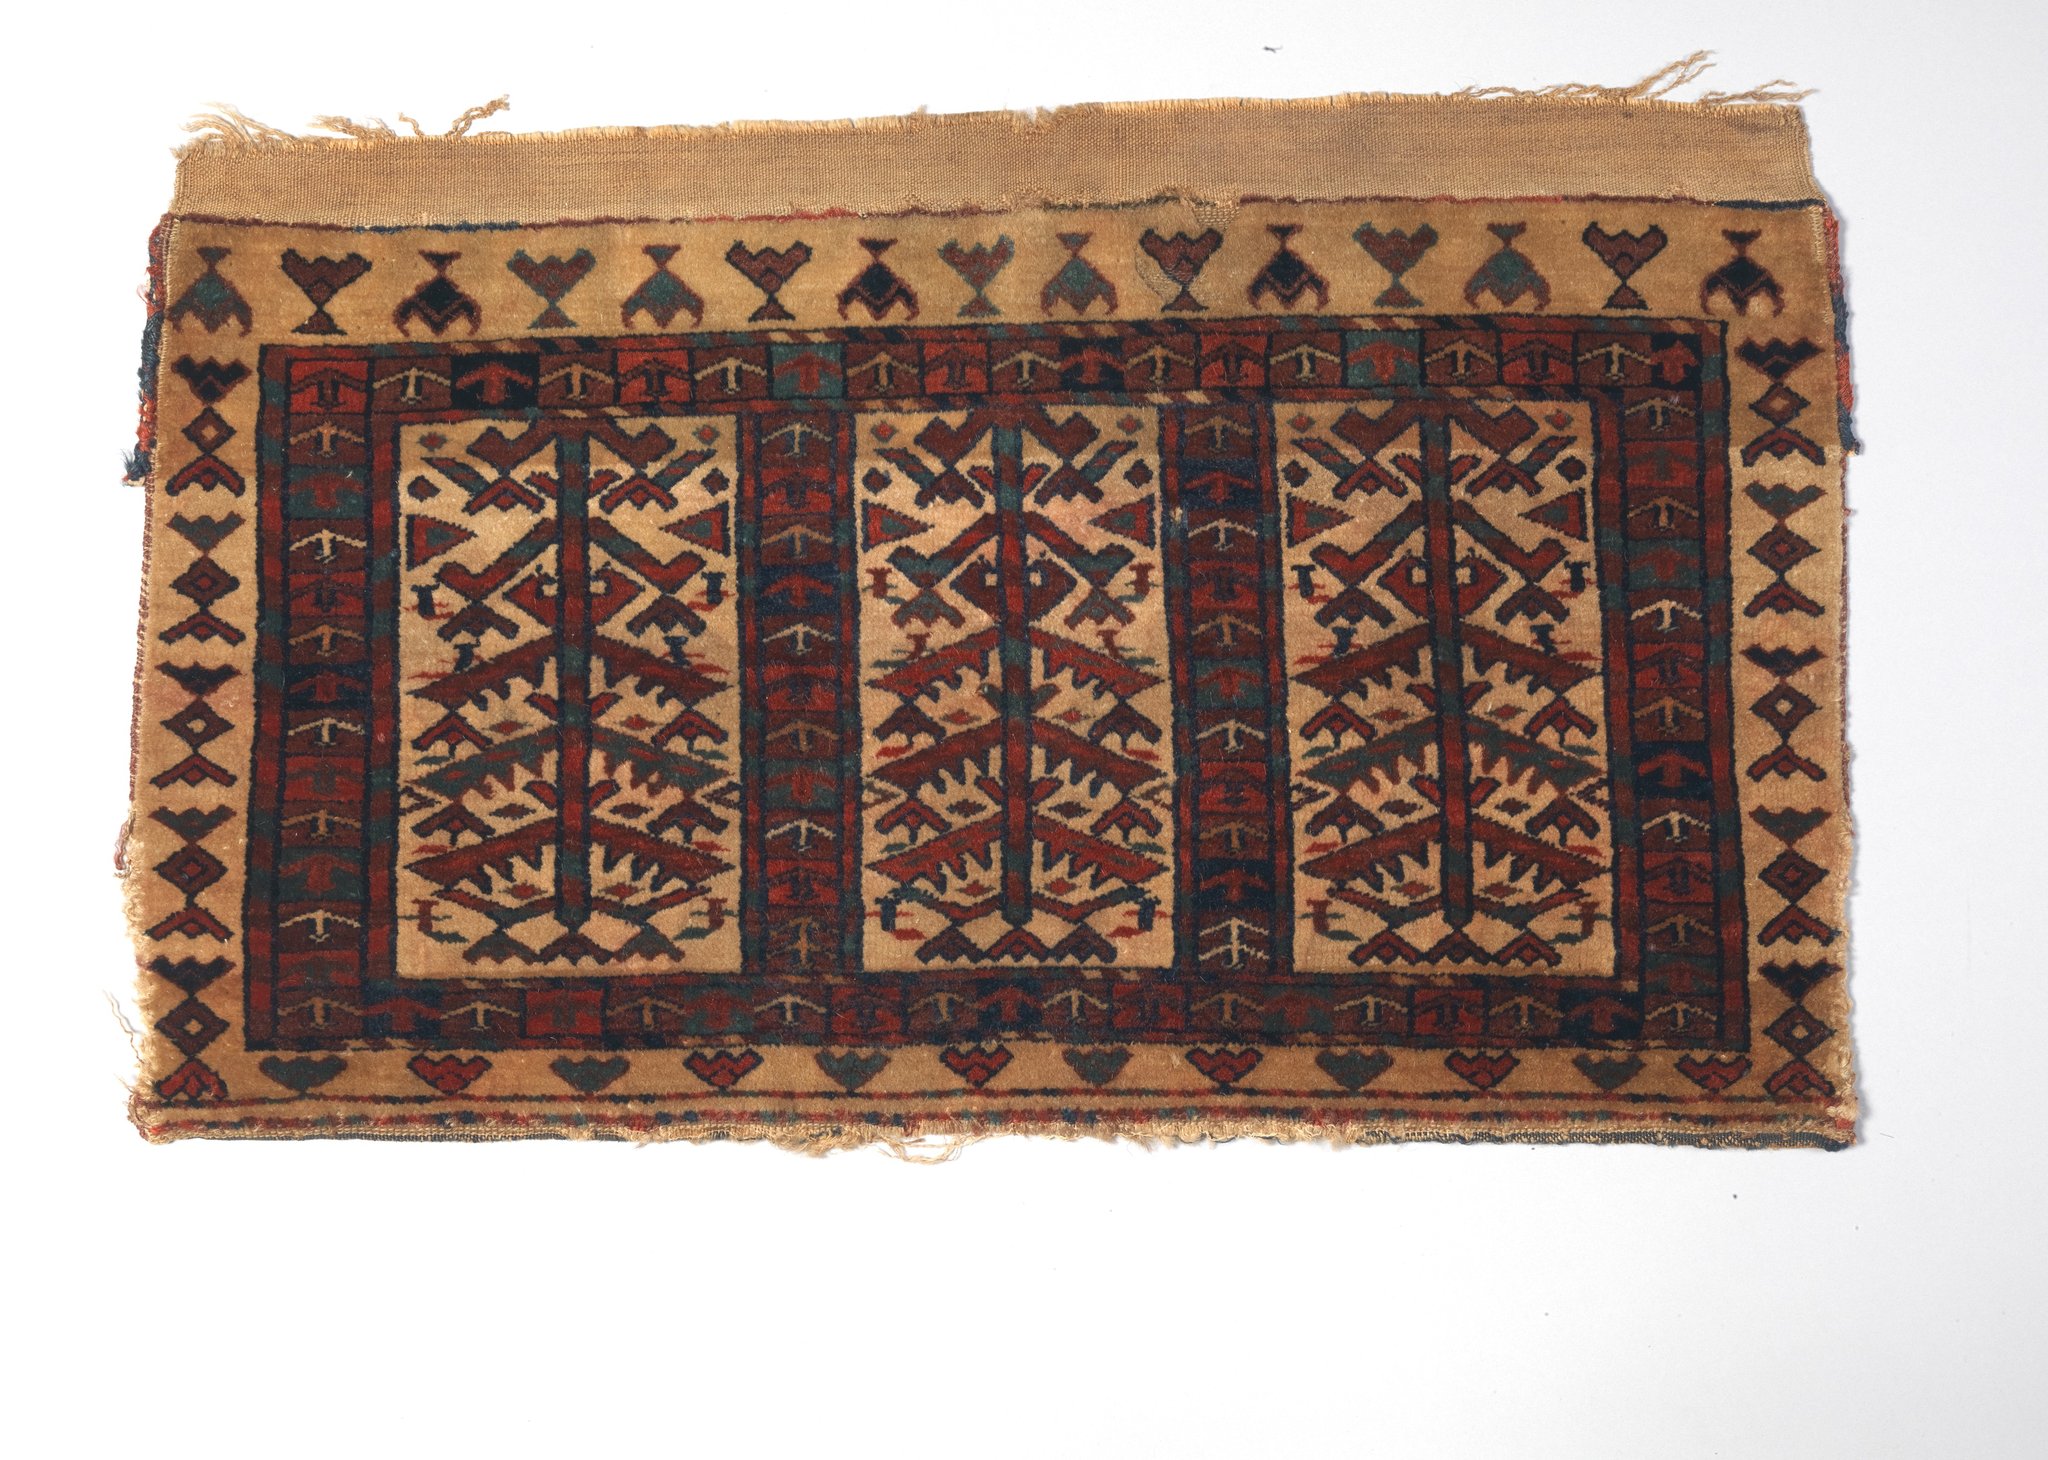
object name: storage bag fragment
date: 1834-1866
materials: wool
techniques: pile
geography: western turkmenistan